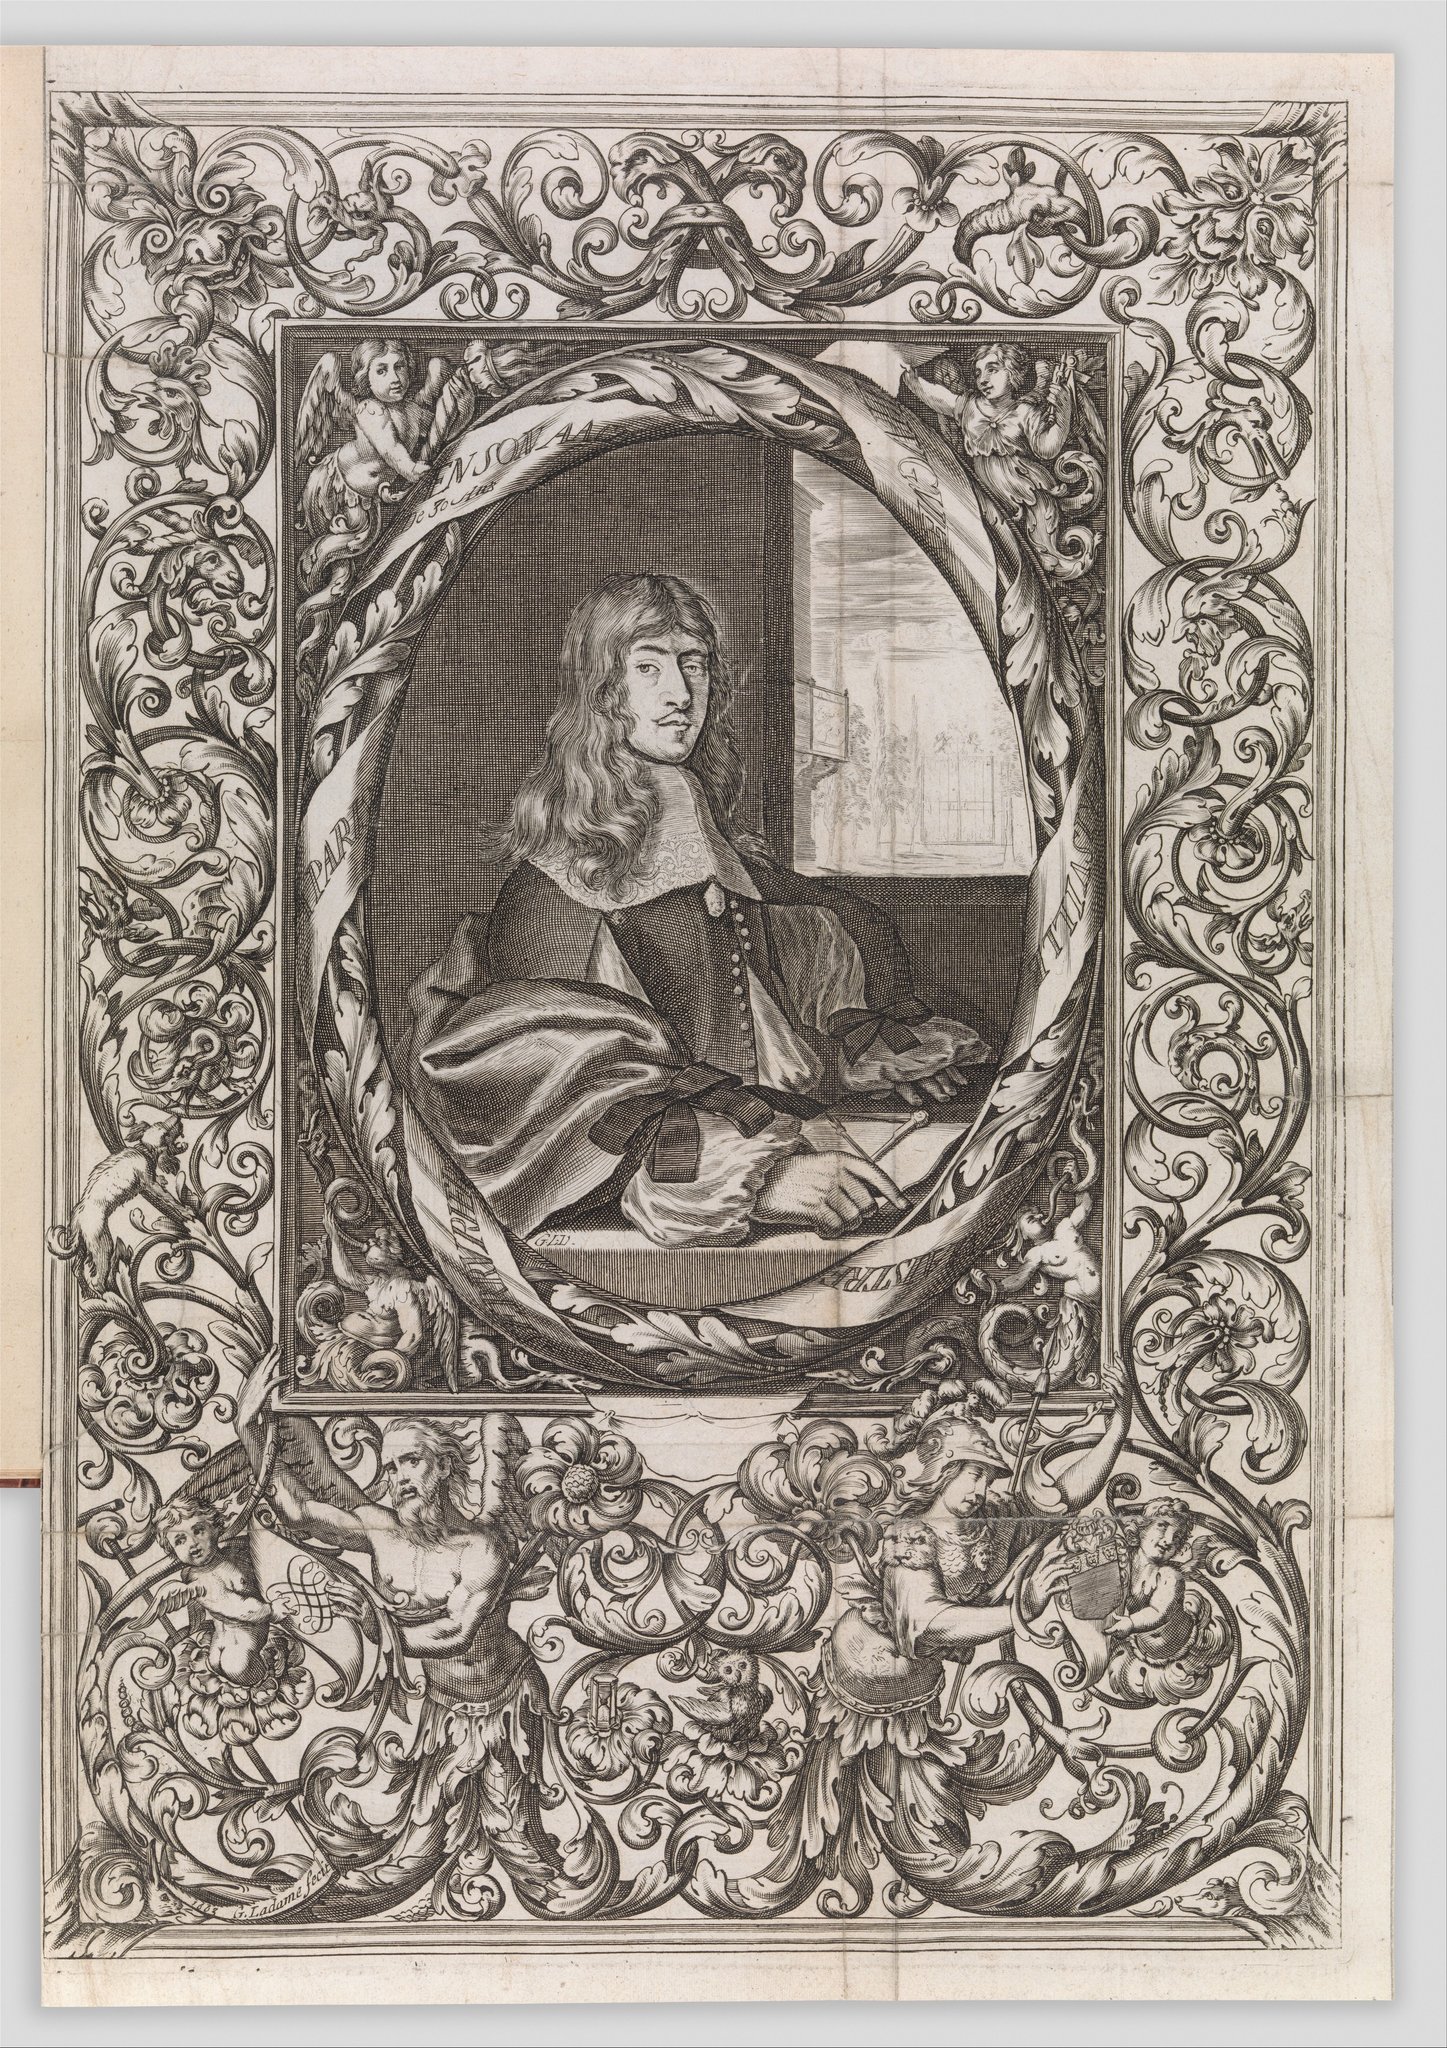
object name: album print ornament architecture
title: Diverses Pieces de Serruriers, page 2 (recto)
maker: jean berain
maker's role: artist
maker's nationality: french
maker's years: 1640-1711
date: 1663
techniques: engraving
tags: men,portraits